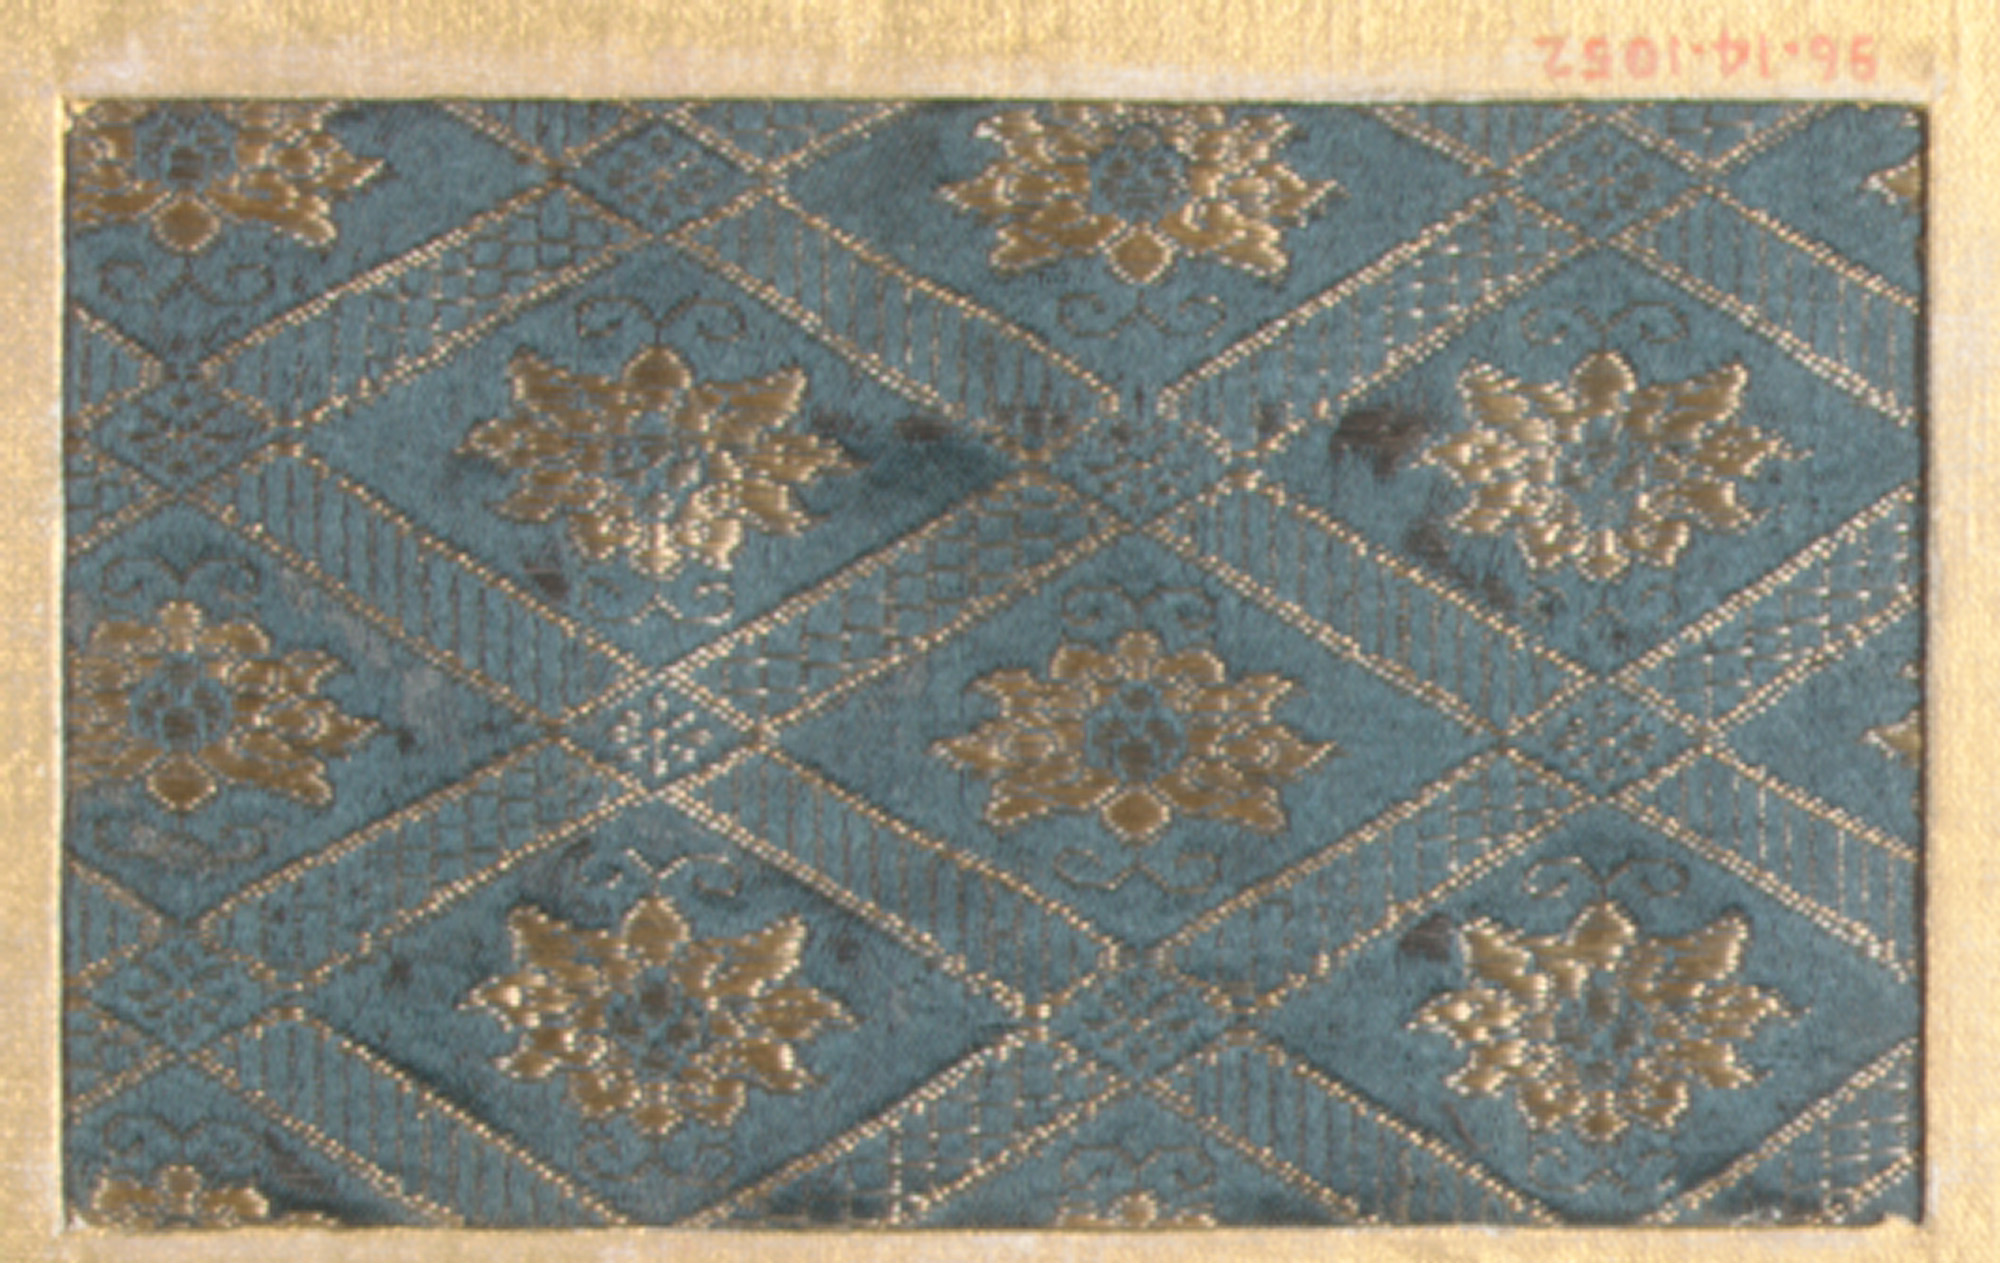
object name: piece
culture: japanese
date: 1701-1900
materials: silk